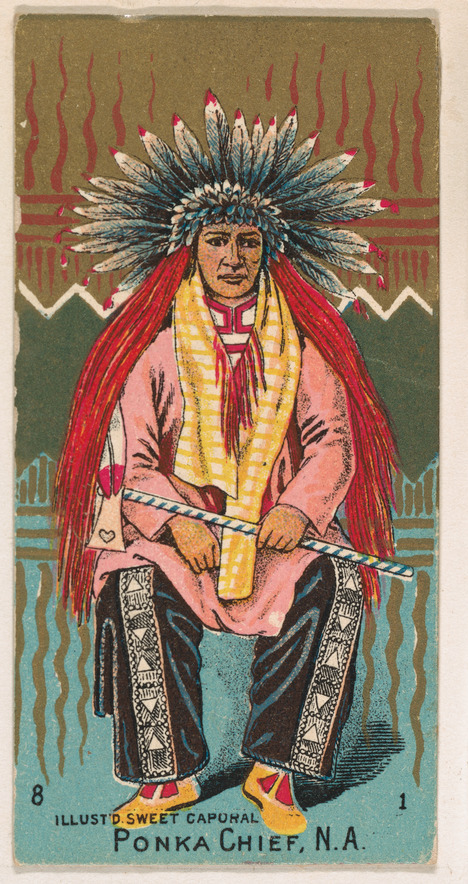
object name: print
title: Ponka Chief, North America, from the Military Series (N224) issued by Kinney Tobacco Company to promote Sweet Caporal Cigarettes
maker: kinney brothers tobacco company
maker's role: publisher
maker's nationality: american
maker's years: 1869-2011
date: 1888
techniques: color lithograph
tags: military,men